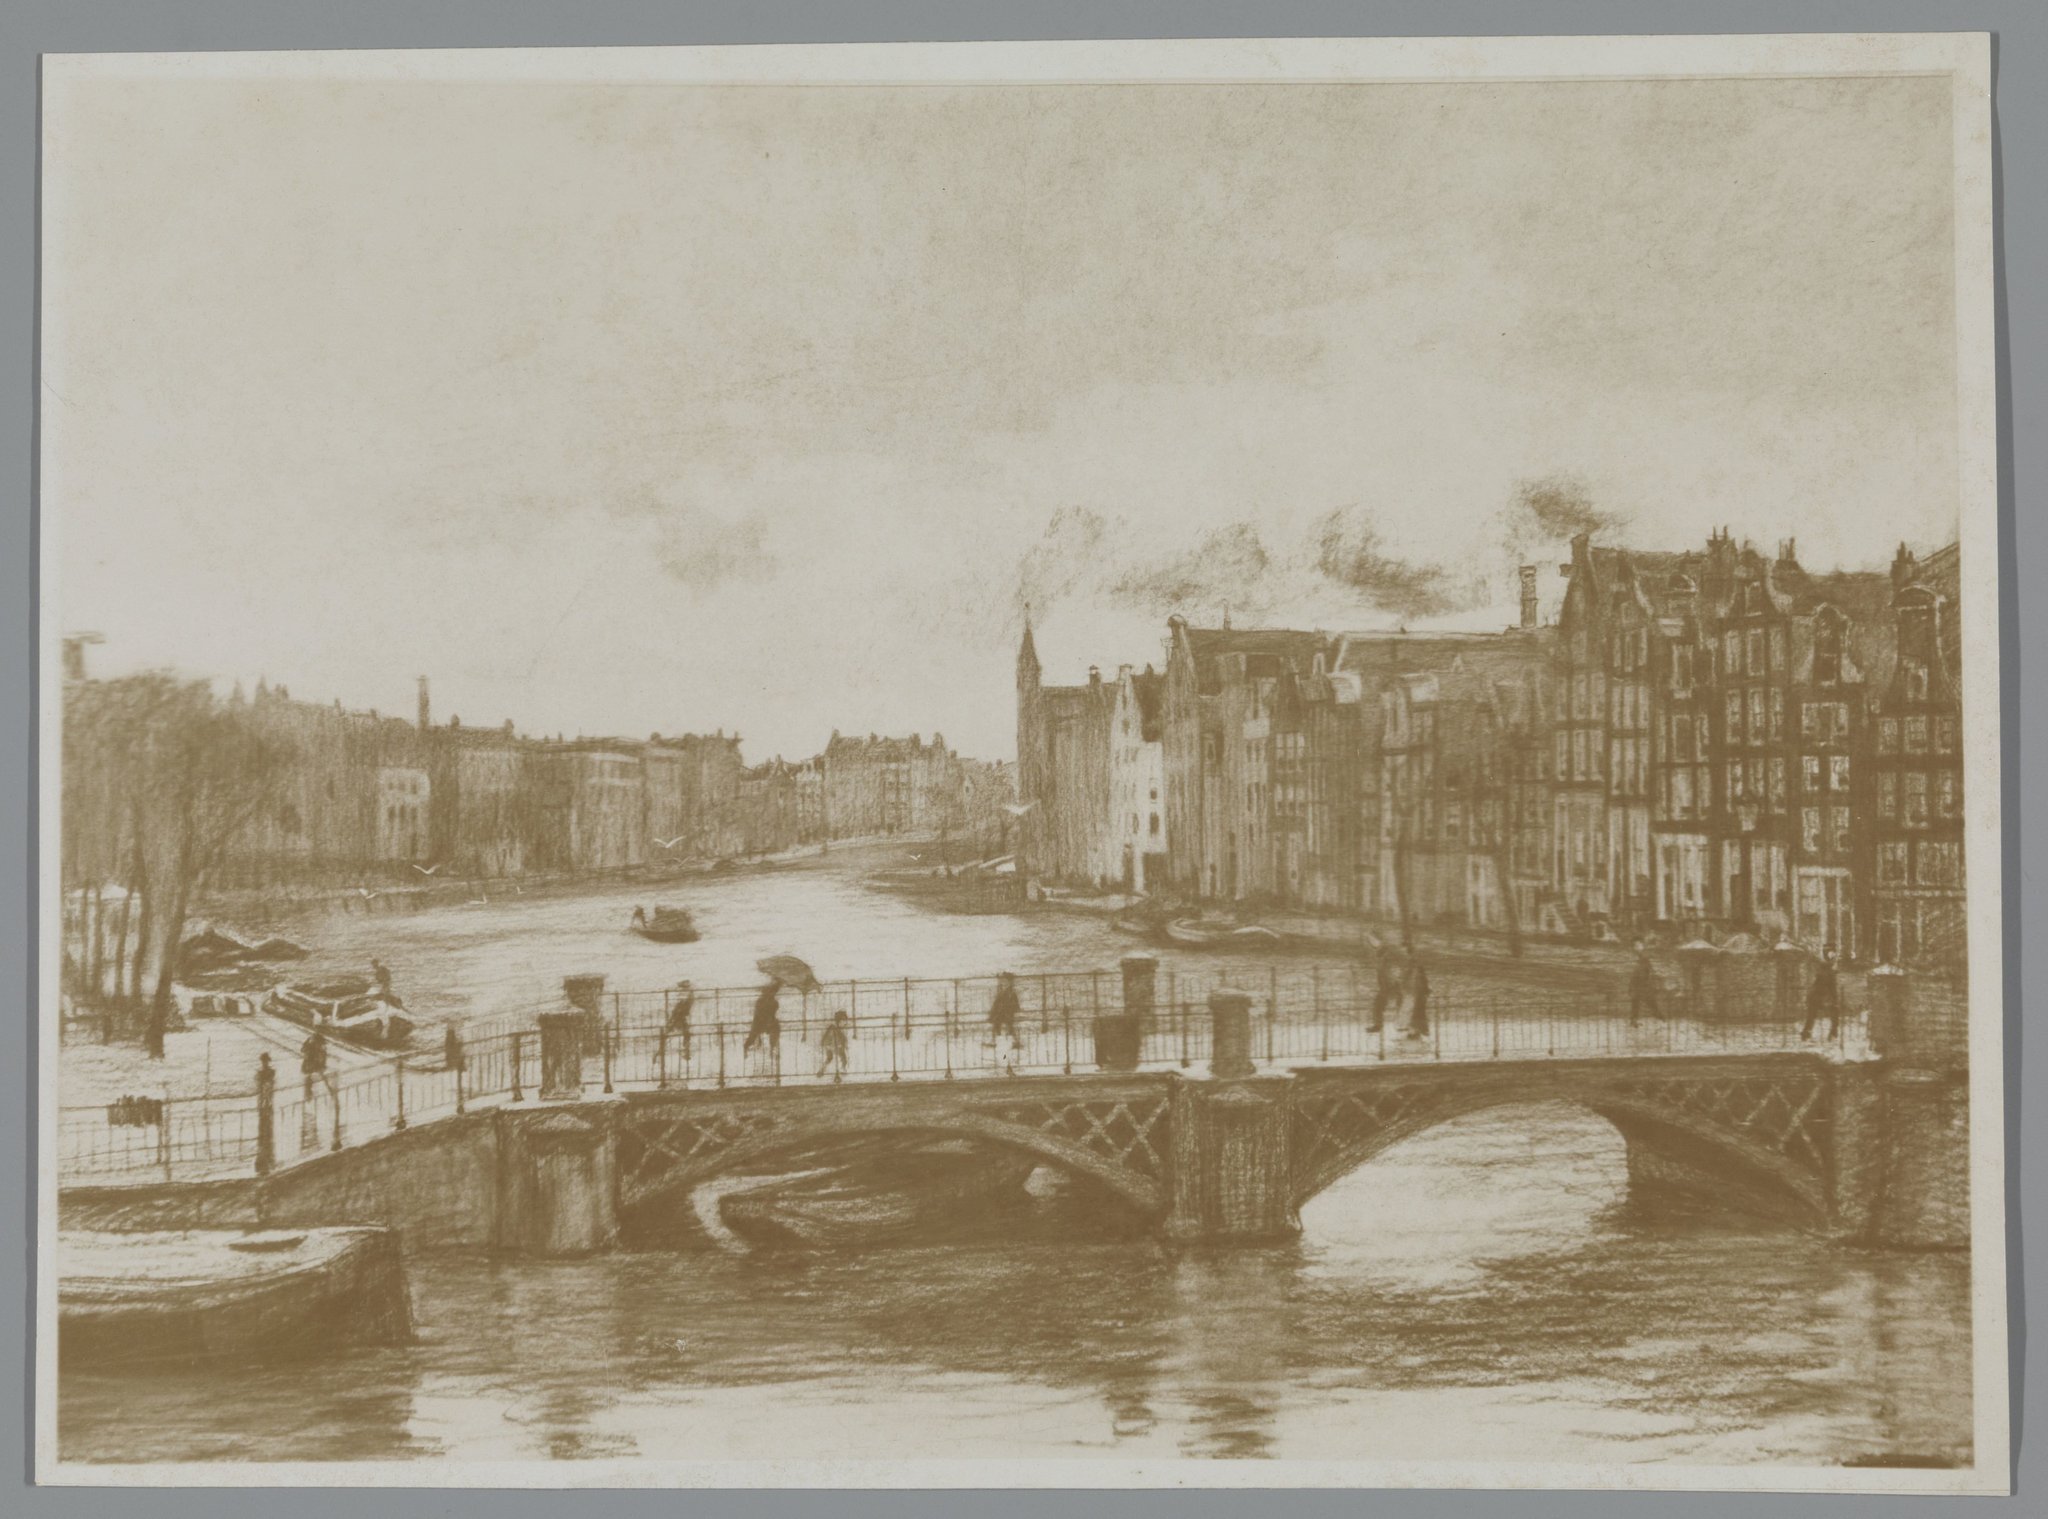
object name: photograph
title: Reproductie naar een foto, schilderij, tekening of prent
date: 1860-1915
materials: paper, photographic support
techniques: collodion silver print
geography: netherlands